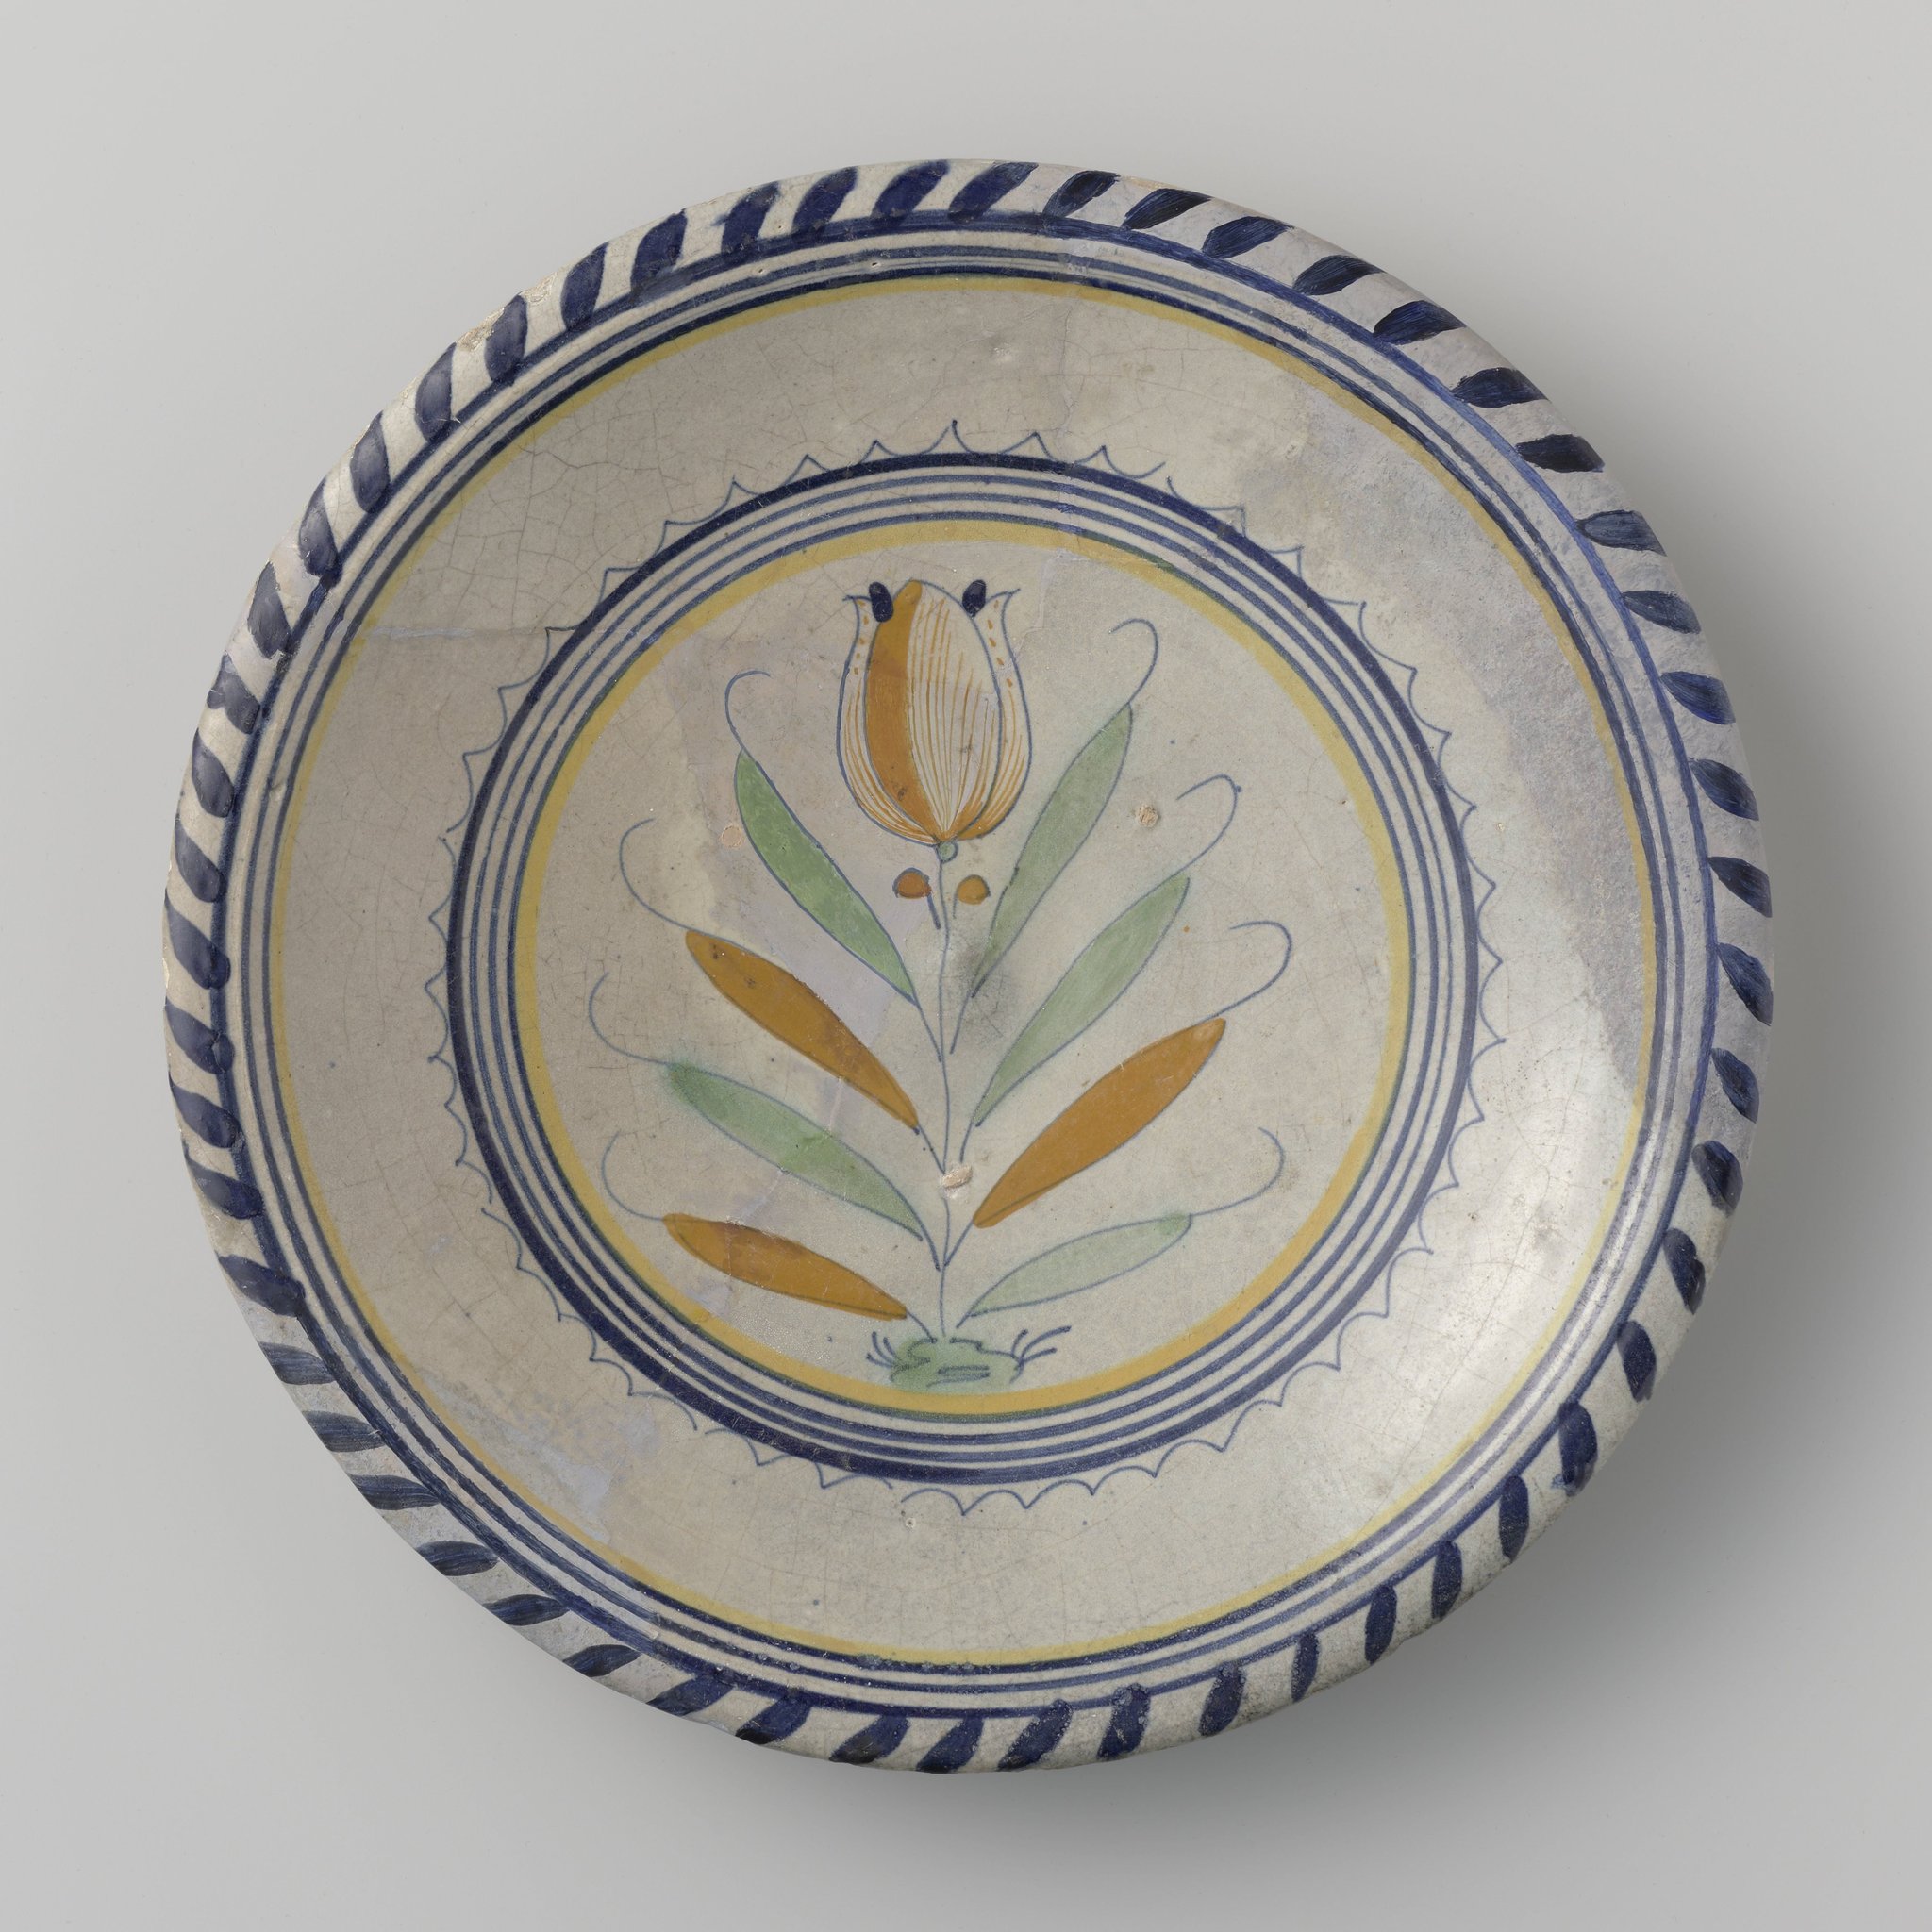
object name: platter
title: Schotel, versierd met tulp binnen vier concentrische cirkels.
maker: Anonymous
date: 1590-1620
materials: earthenware, glaze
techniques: maiolica, painted, polychromy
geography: netherlands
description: Schotel van veelkleurig beschilderde majolica. Op de schotel is een tulp geschilderd binnen vier blauwe, concentrische cirkels. Langs de rand zijn strepen geschilderd.